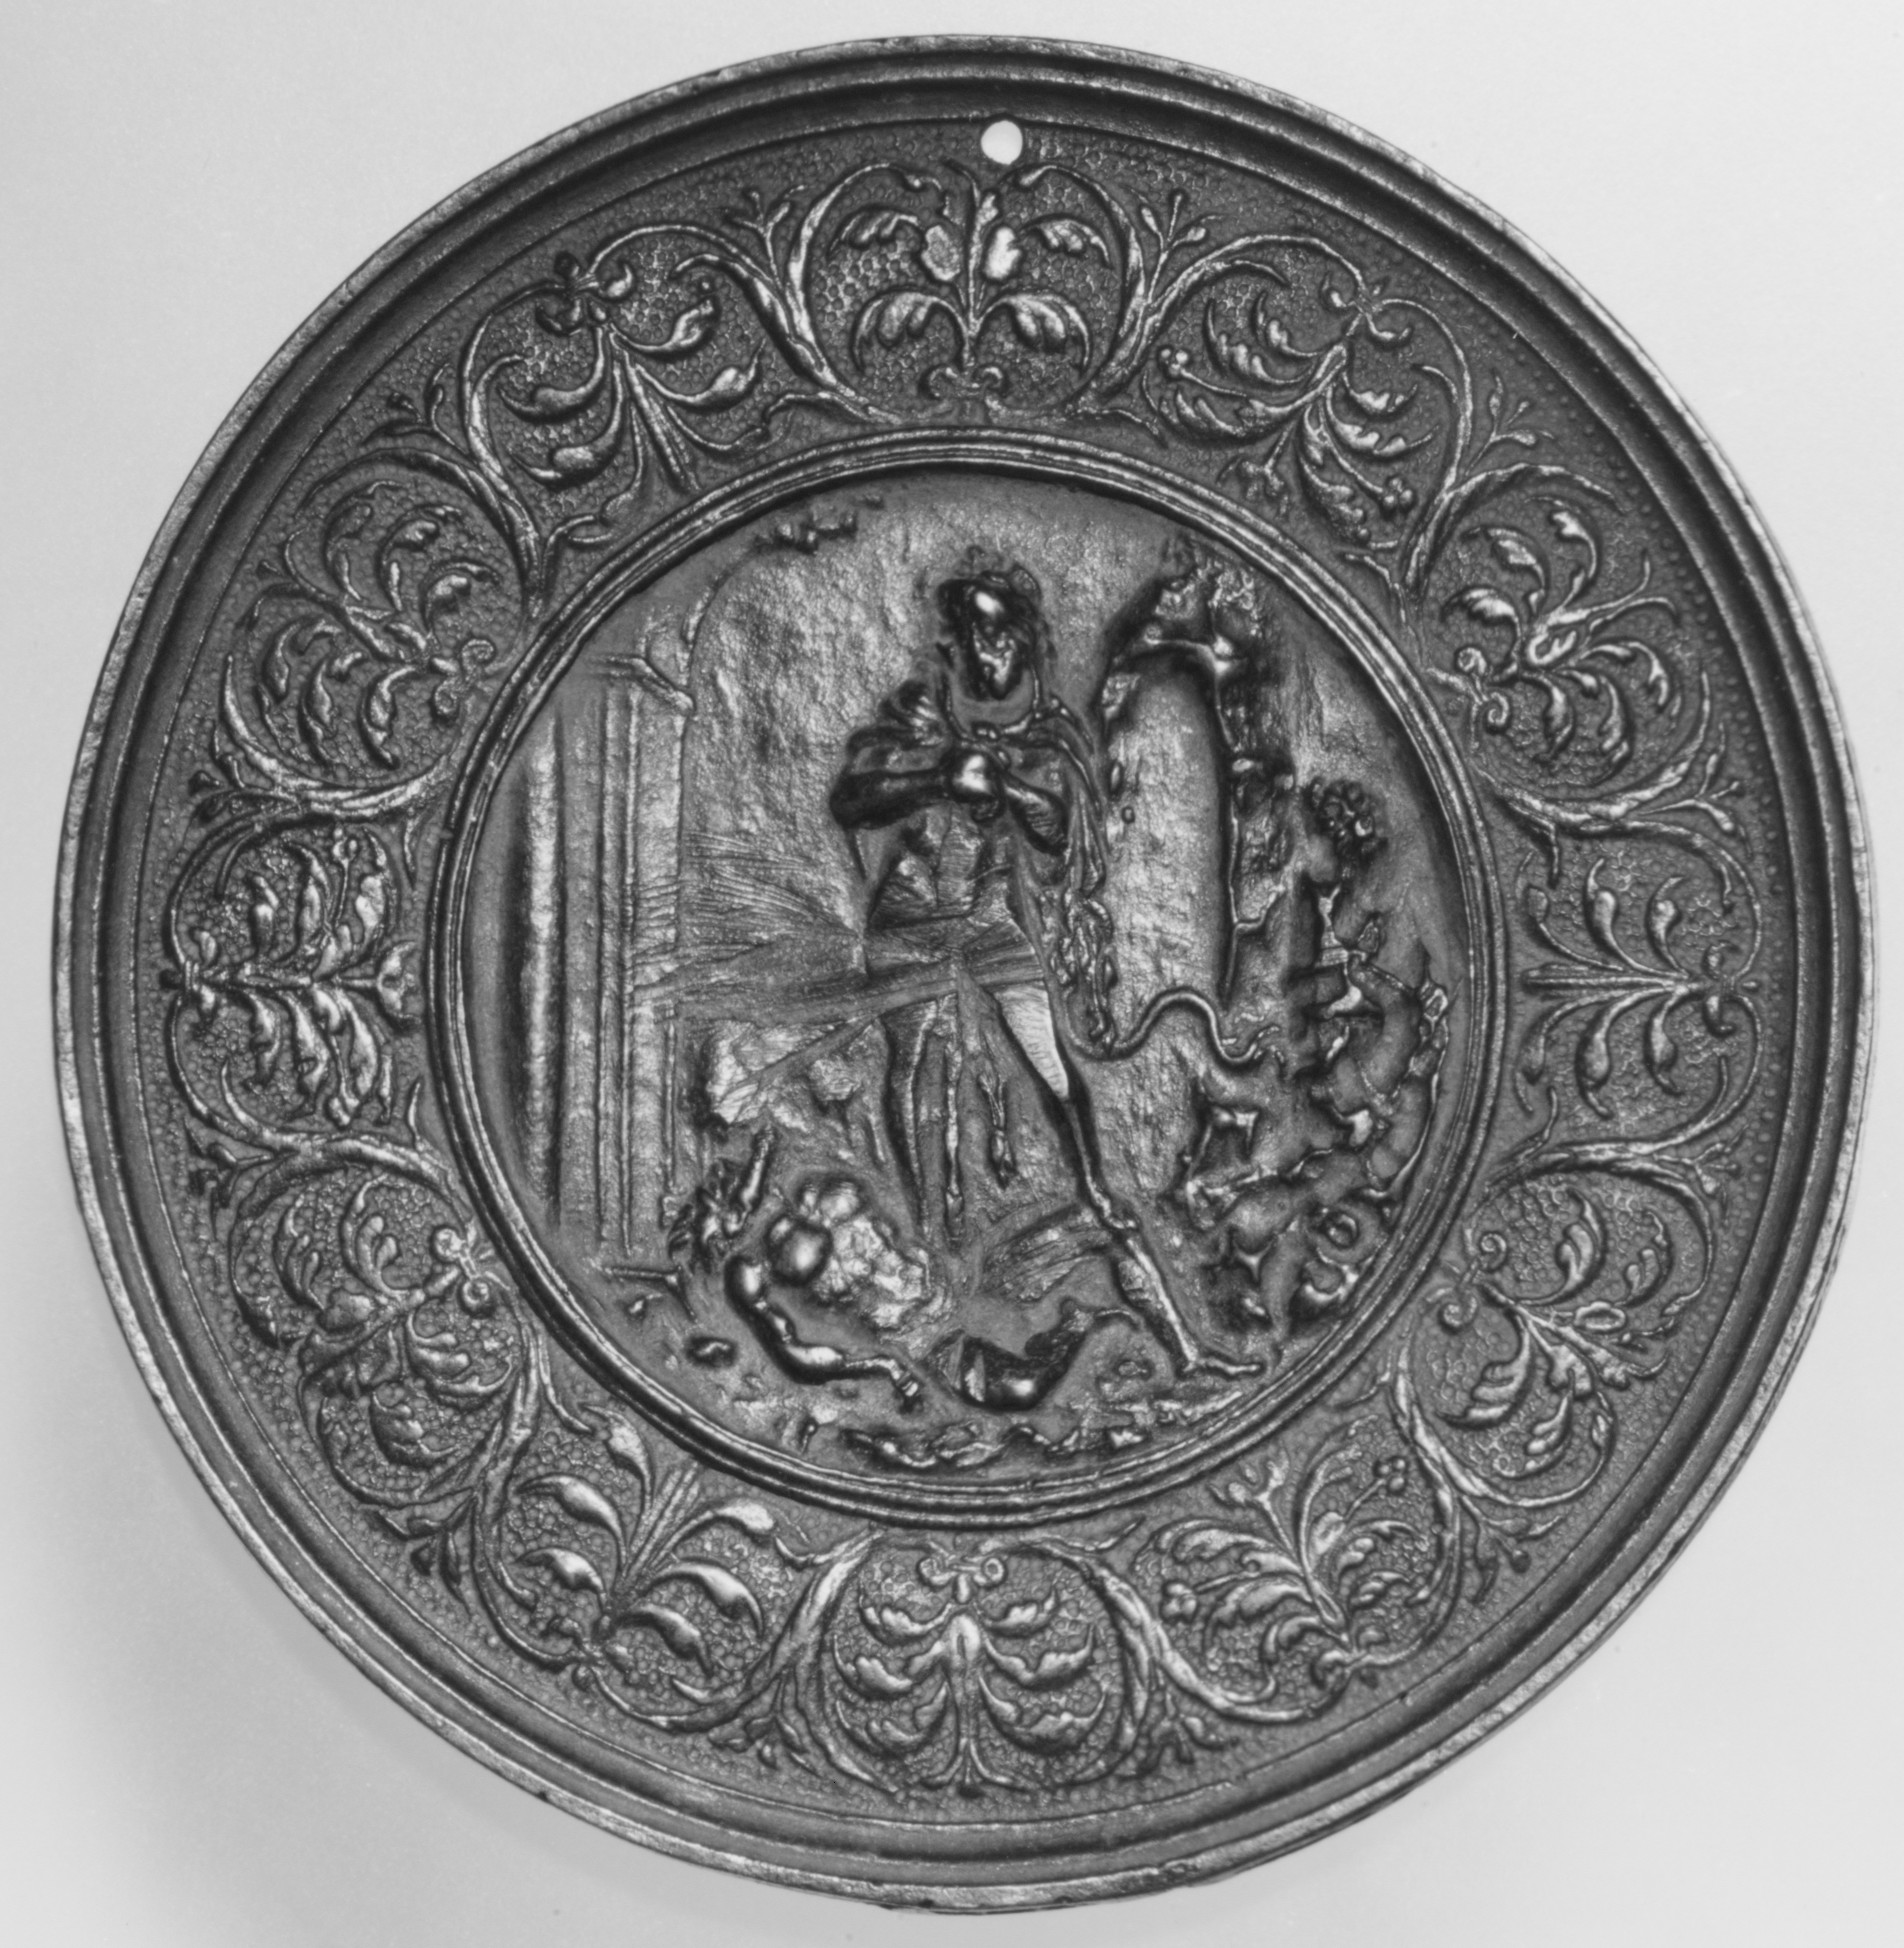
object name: plaquette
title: Hercules triumphant over Antaeus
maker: moderno (galeazzo mondella)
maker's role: artist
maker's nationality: italian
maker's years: 1467-1528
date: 1501-1533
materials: bronze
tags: hercules